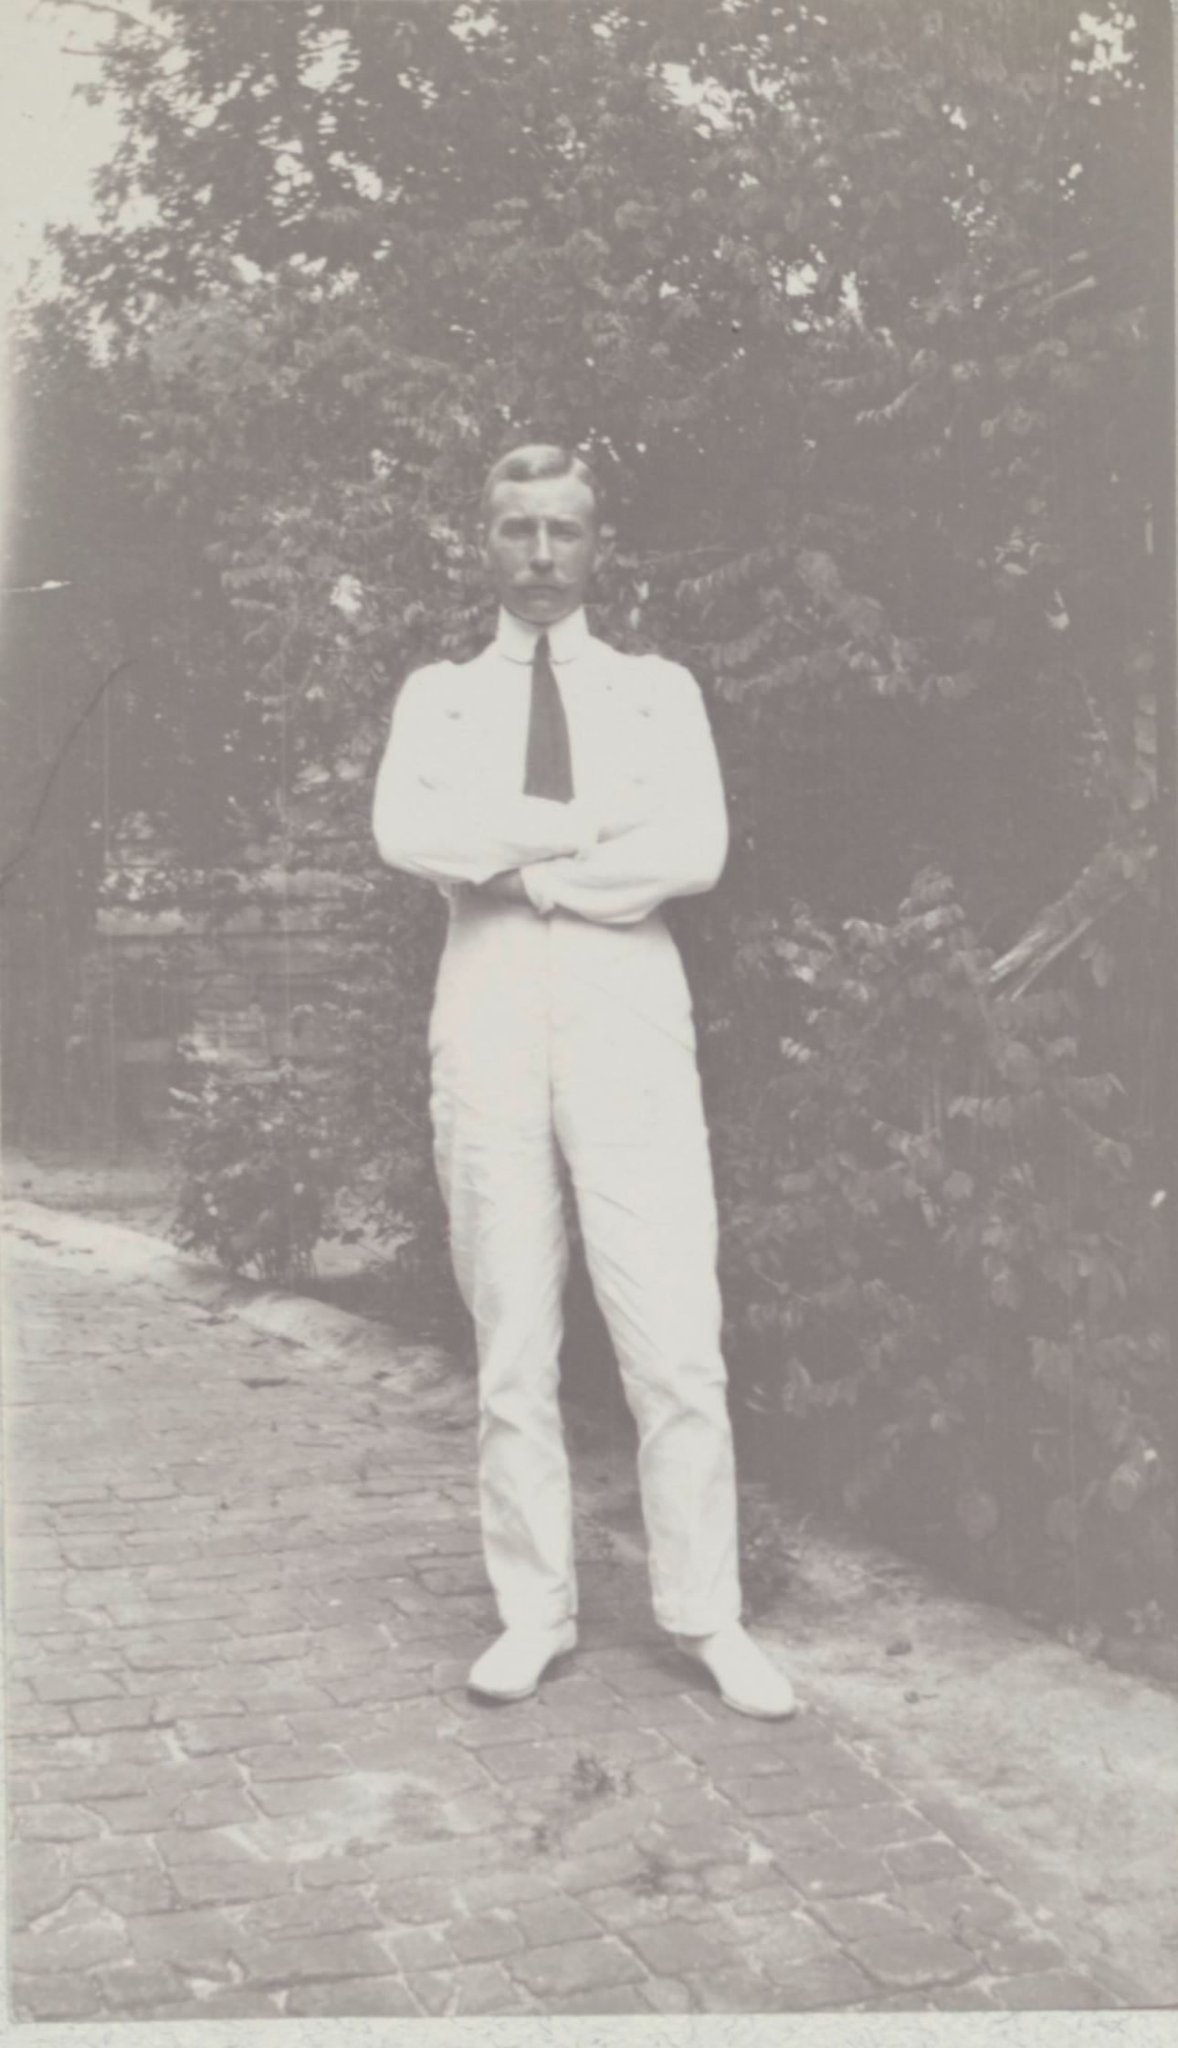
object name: photograph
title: Andries Boom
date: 1911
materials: photographic support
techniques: photography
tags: andries augustus boom, suriname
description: Andries Boom staande met zijn armen over elkaar. Onderdeel van het fotoalbum van de familie Boom-Gonggrijp in Suriname en Curaçao.